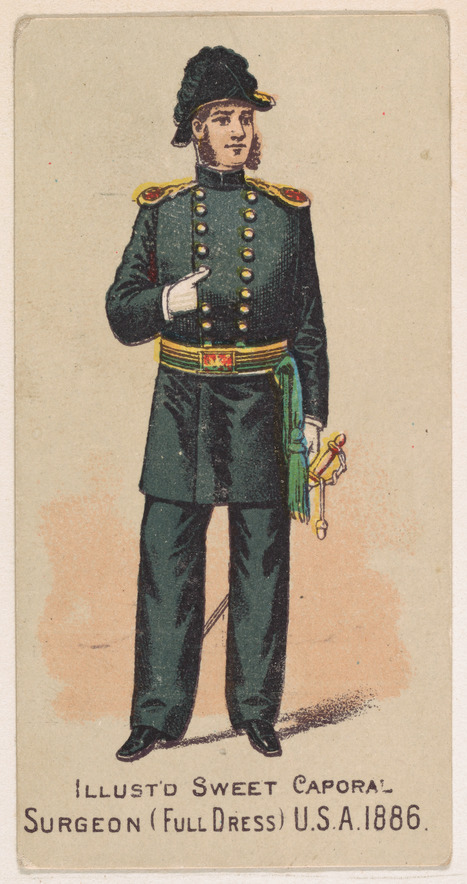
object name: print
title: Full Dress, Surgeon, United States Army, 1886, from the Military Series (N224) issued by Kinney Tobacco Company to promote Sweet Caporal Cigarettes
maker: kinney brothers tobacco company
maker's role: publisher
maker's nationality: american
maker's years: 1869-2011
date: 1888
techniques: color lithograph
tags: military,men